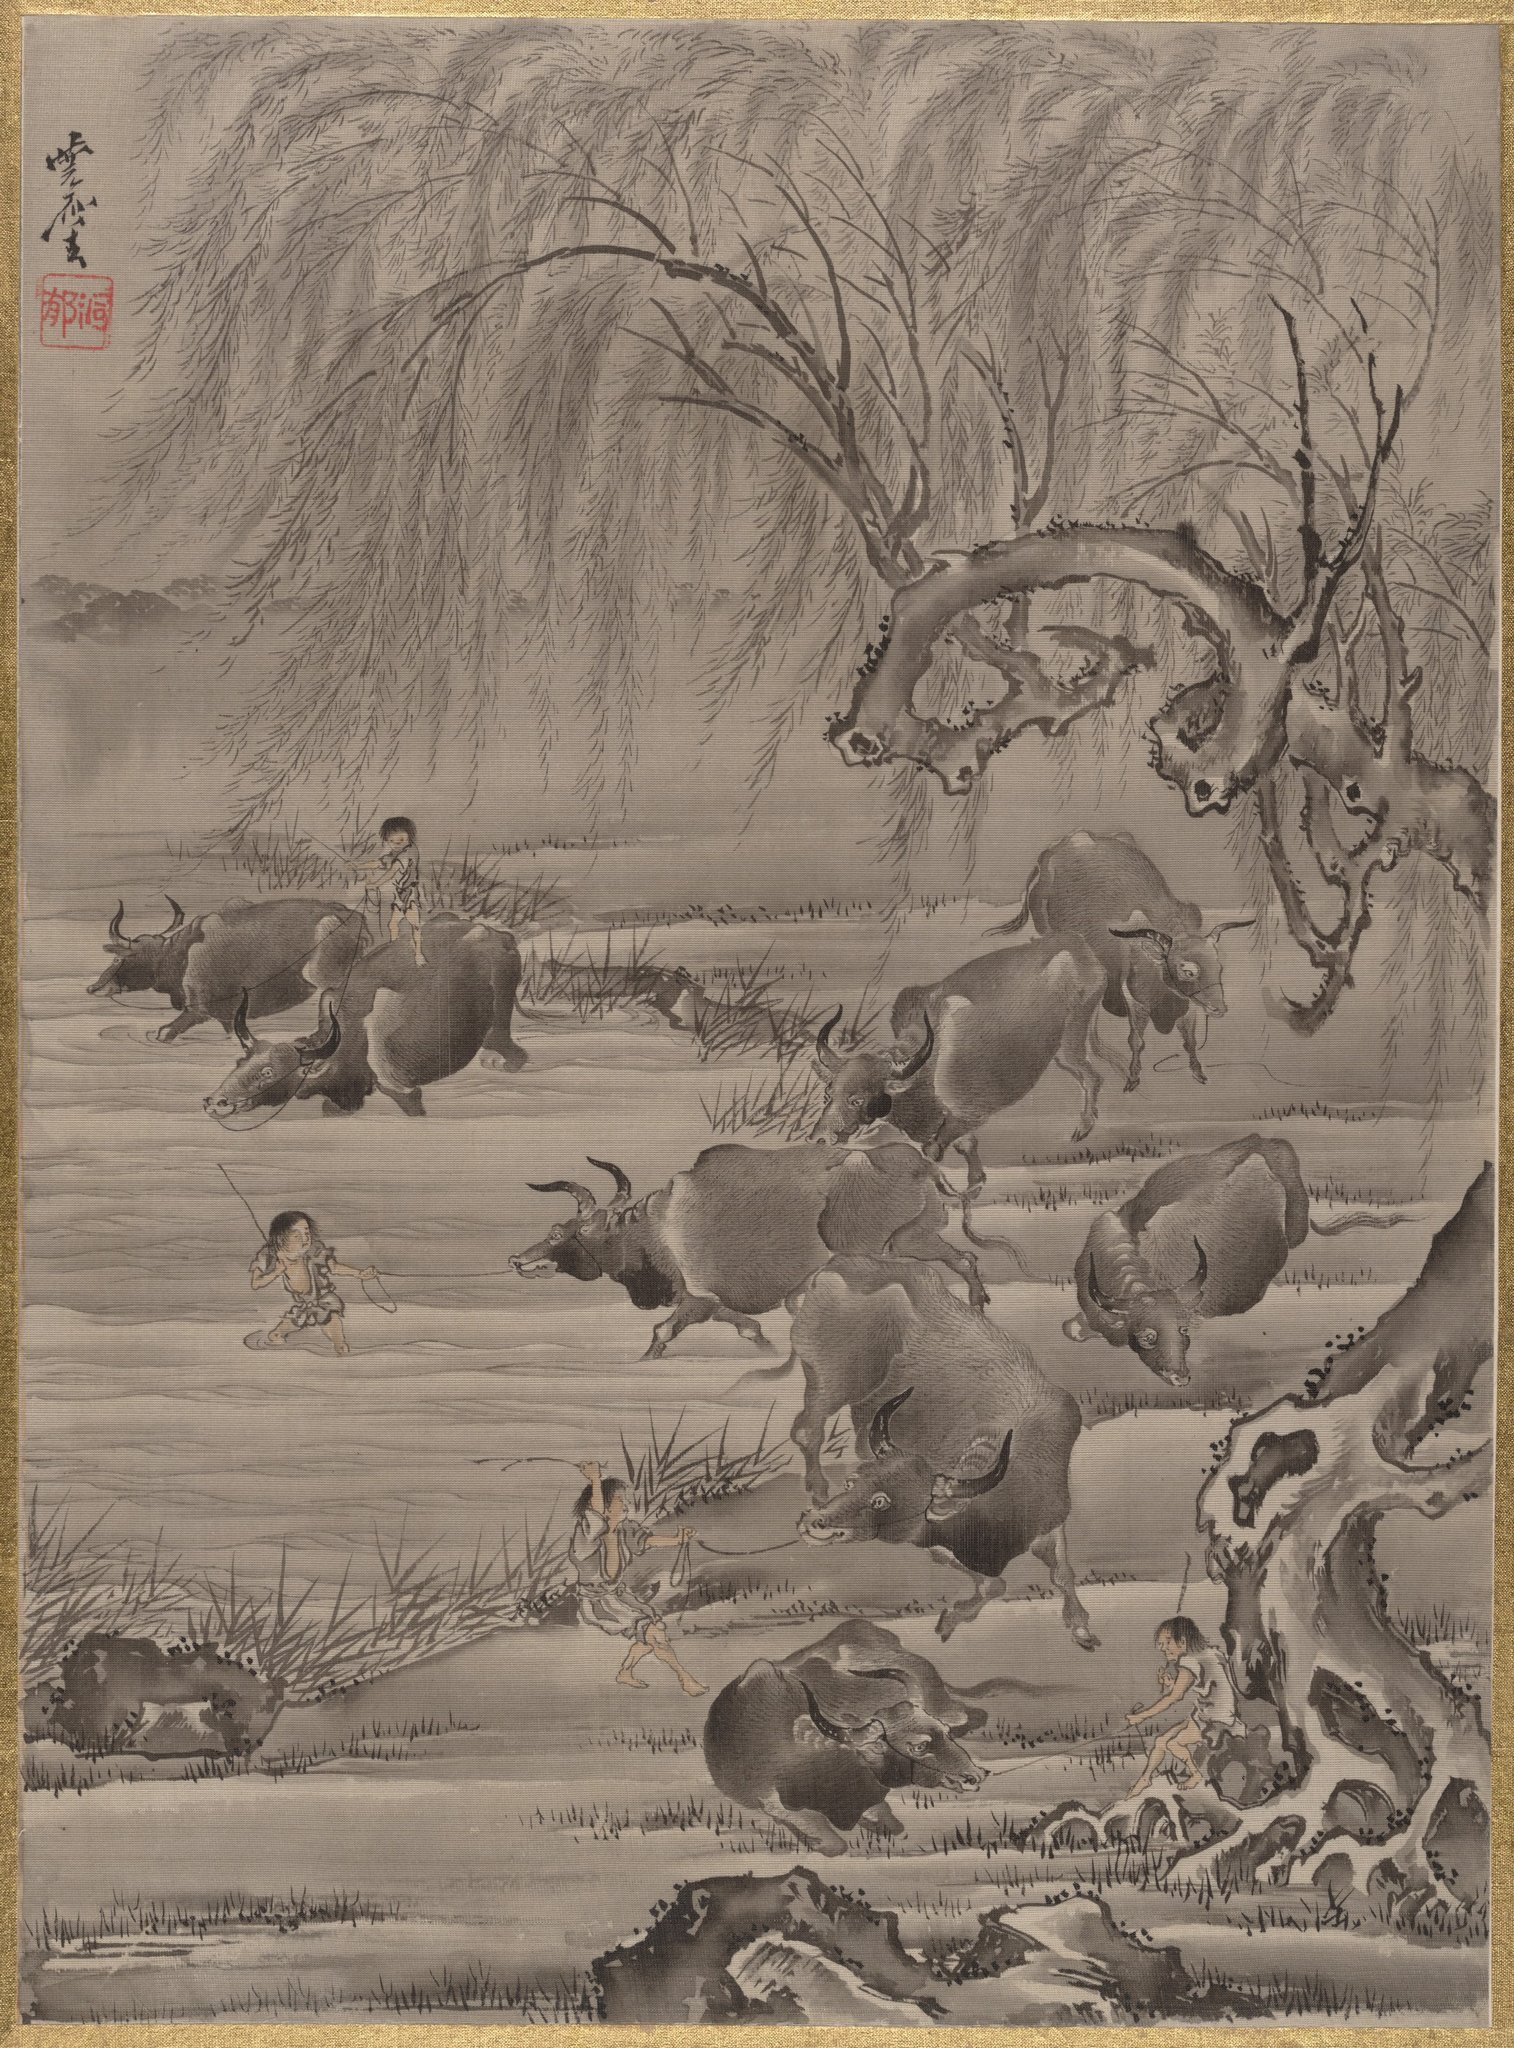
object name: album leaf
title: Buffalo and Herdsman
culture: japanese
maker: kawanabe kyōsai 河鍋暁斎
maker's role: artist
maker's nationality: japanese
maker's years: 1831-1889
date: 1887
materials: ink, silk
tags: men,buffalos